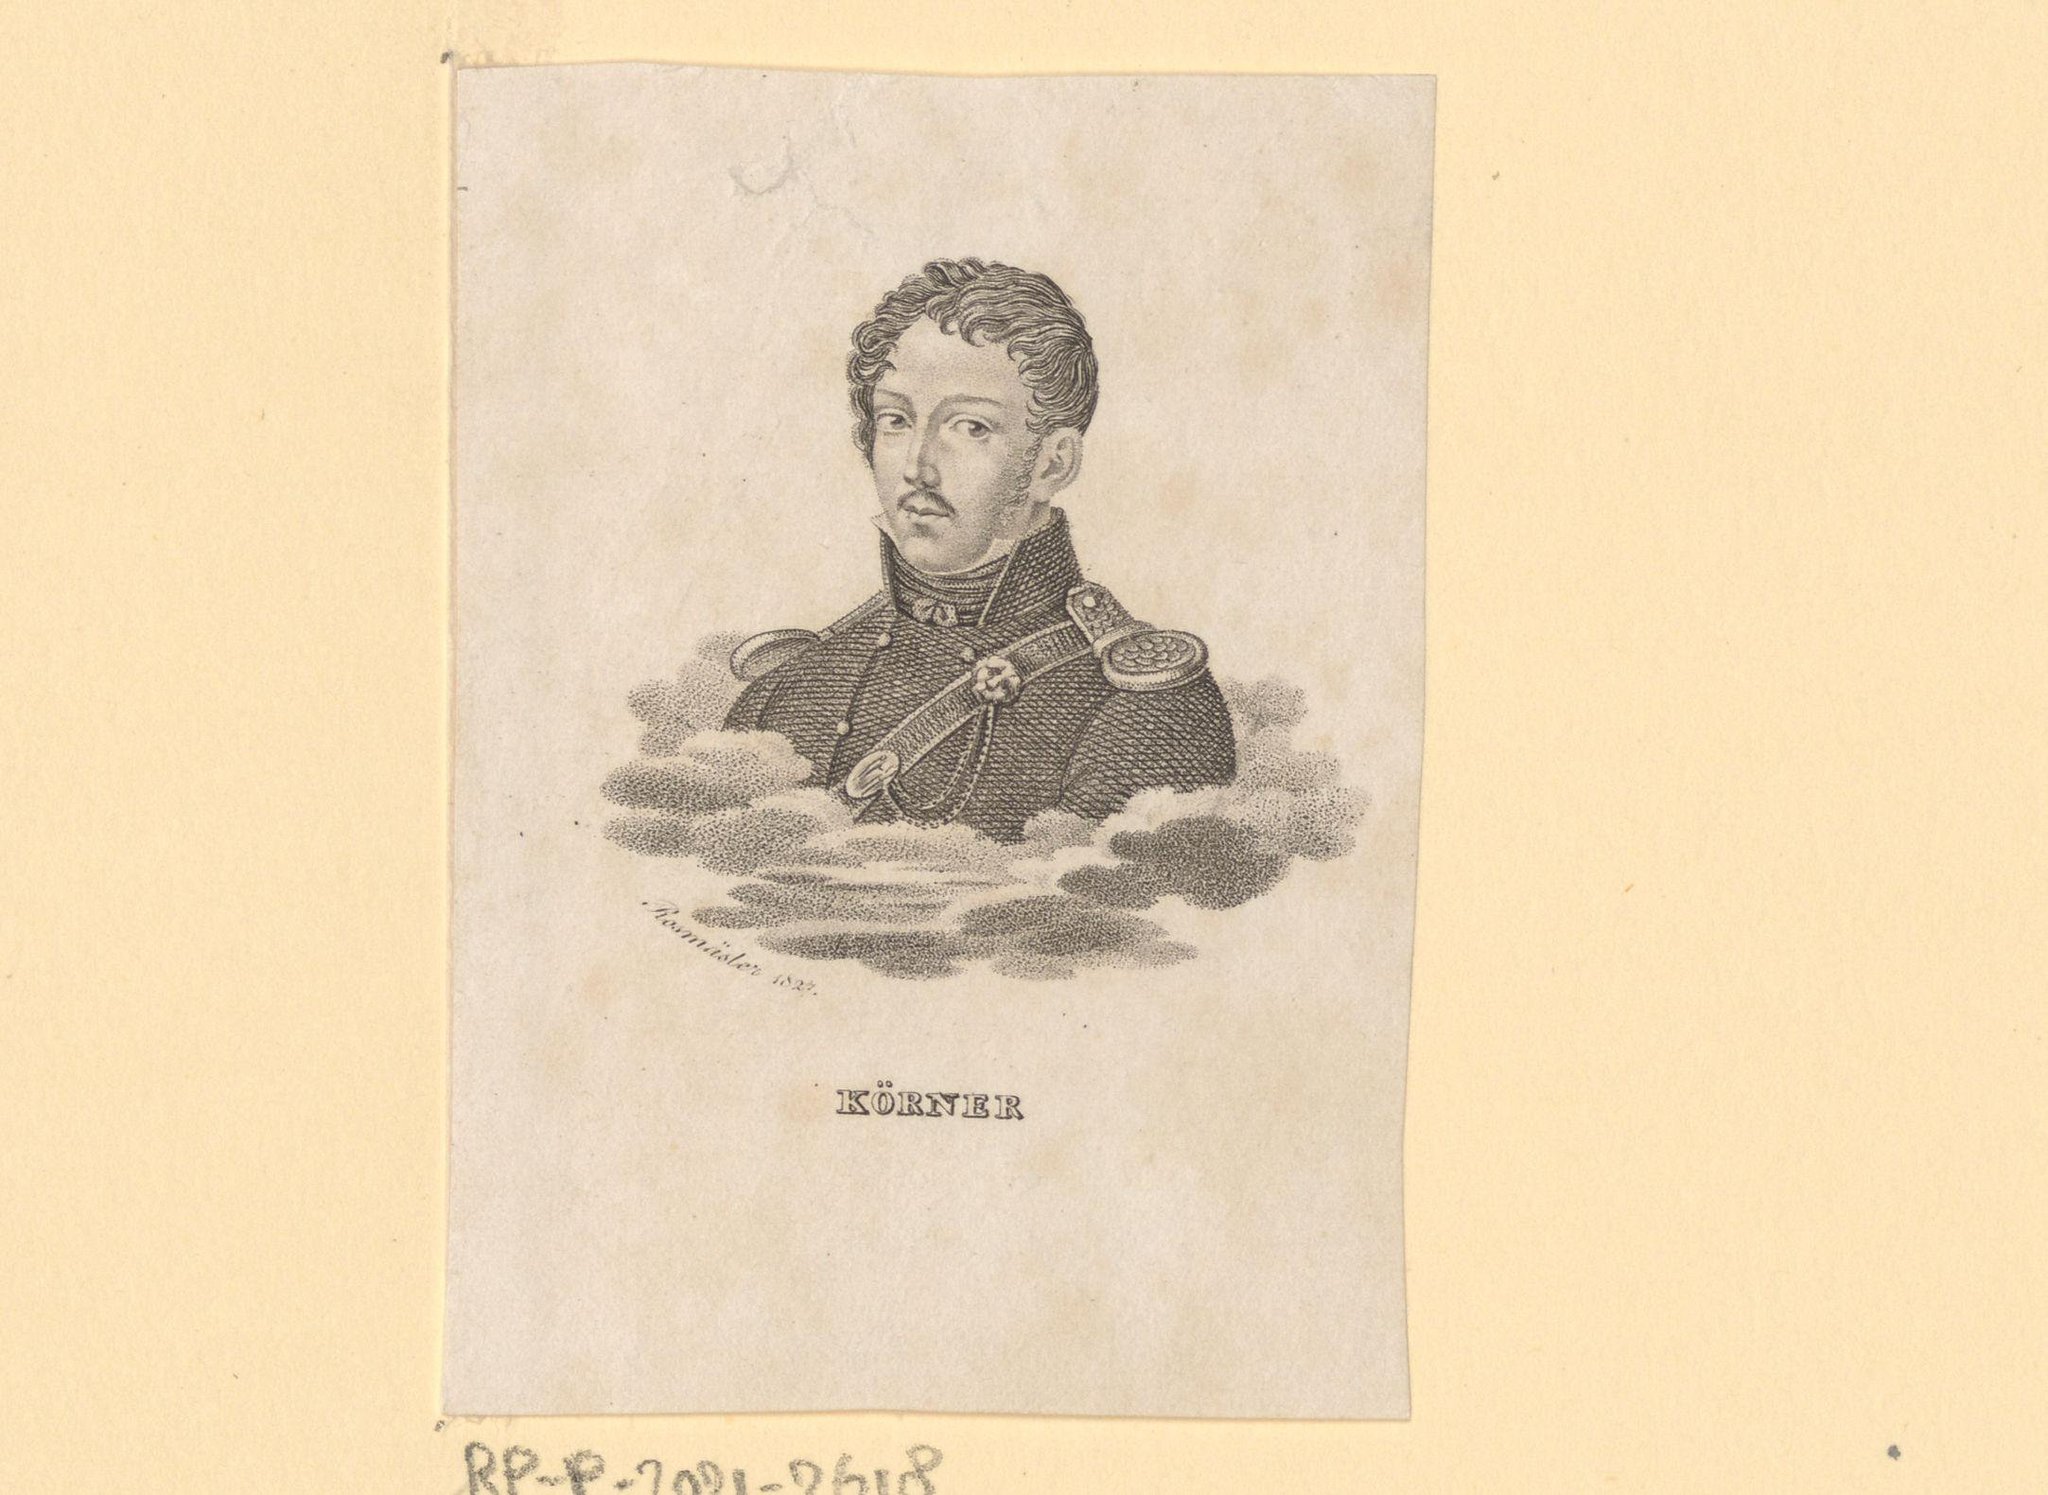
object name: print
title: Portret van Theodor Körner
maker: friedrich rossmässler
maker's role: print maker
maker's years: 1775-1858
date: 1827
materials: paper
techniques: engraving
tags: historical persons, writer, poet, author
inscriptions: date